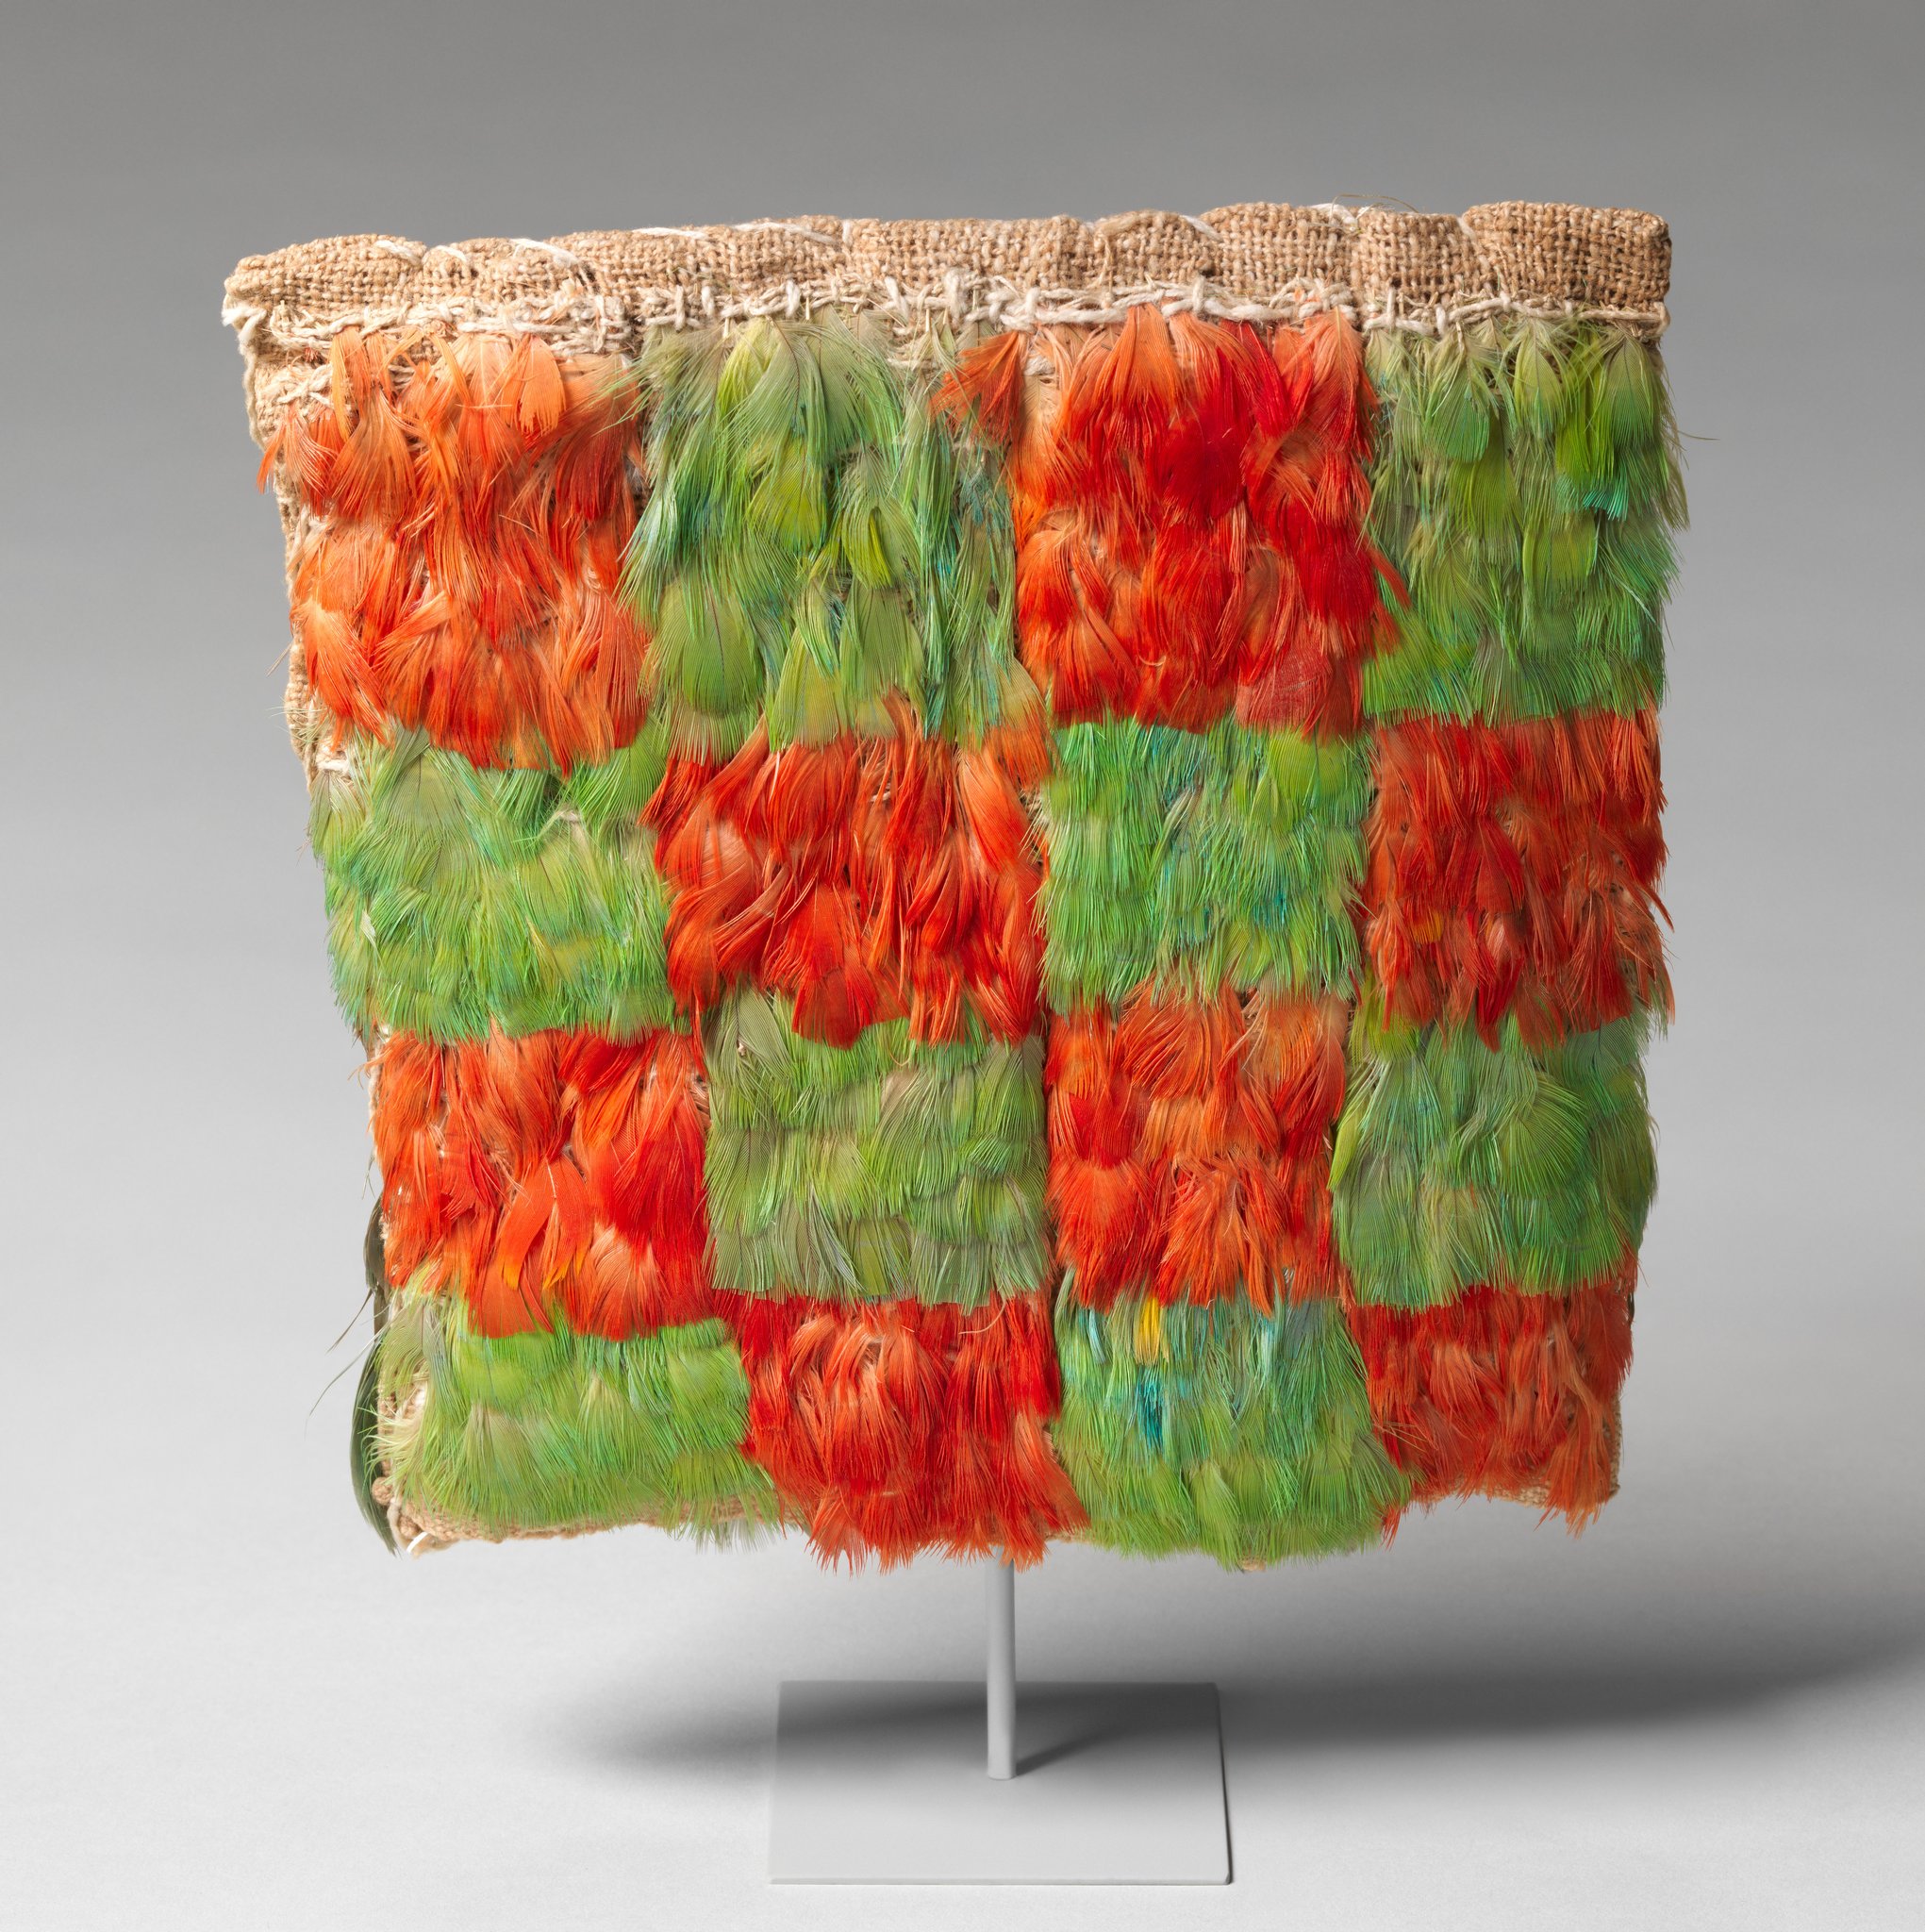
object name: miniature dress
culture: ica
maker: ica artist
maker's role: artist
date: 1101-1300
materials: cotton, feather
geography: peru